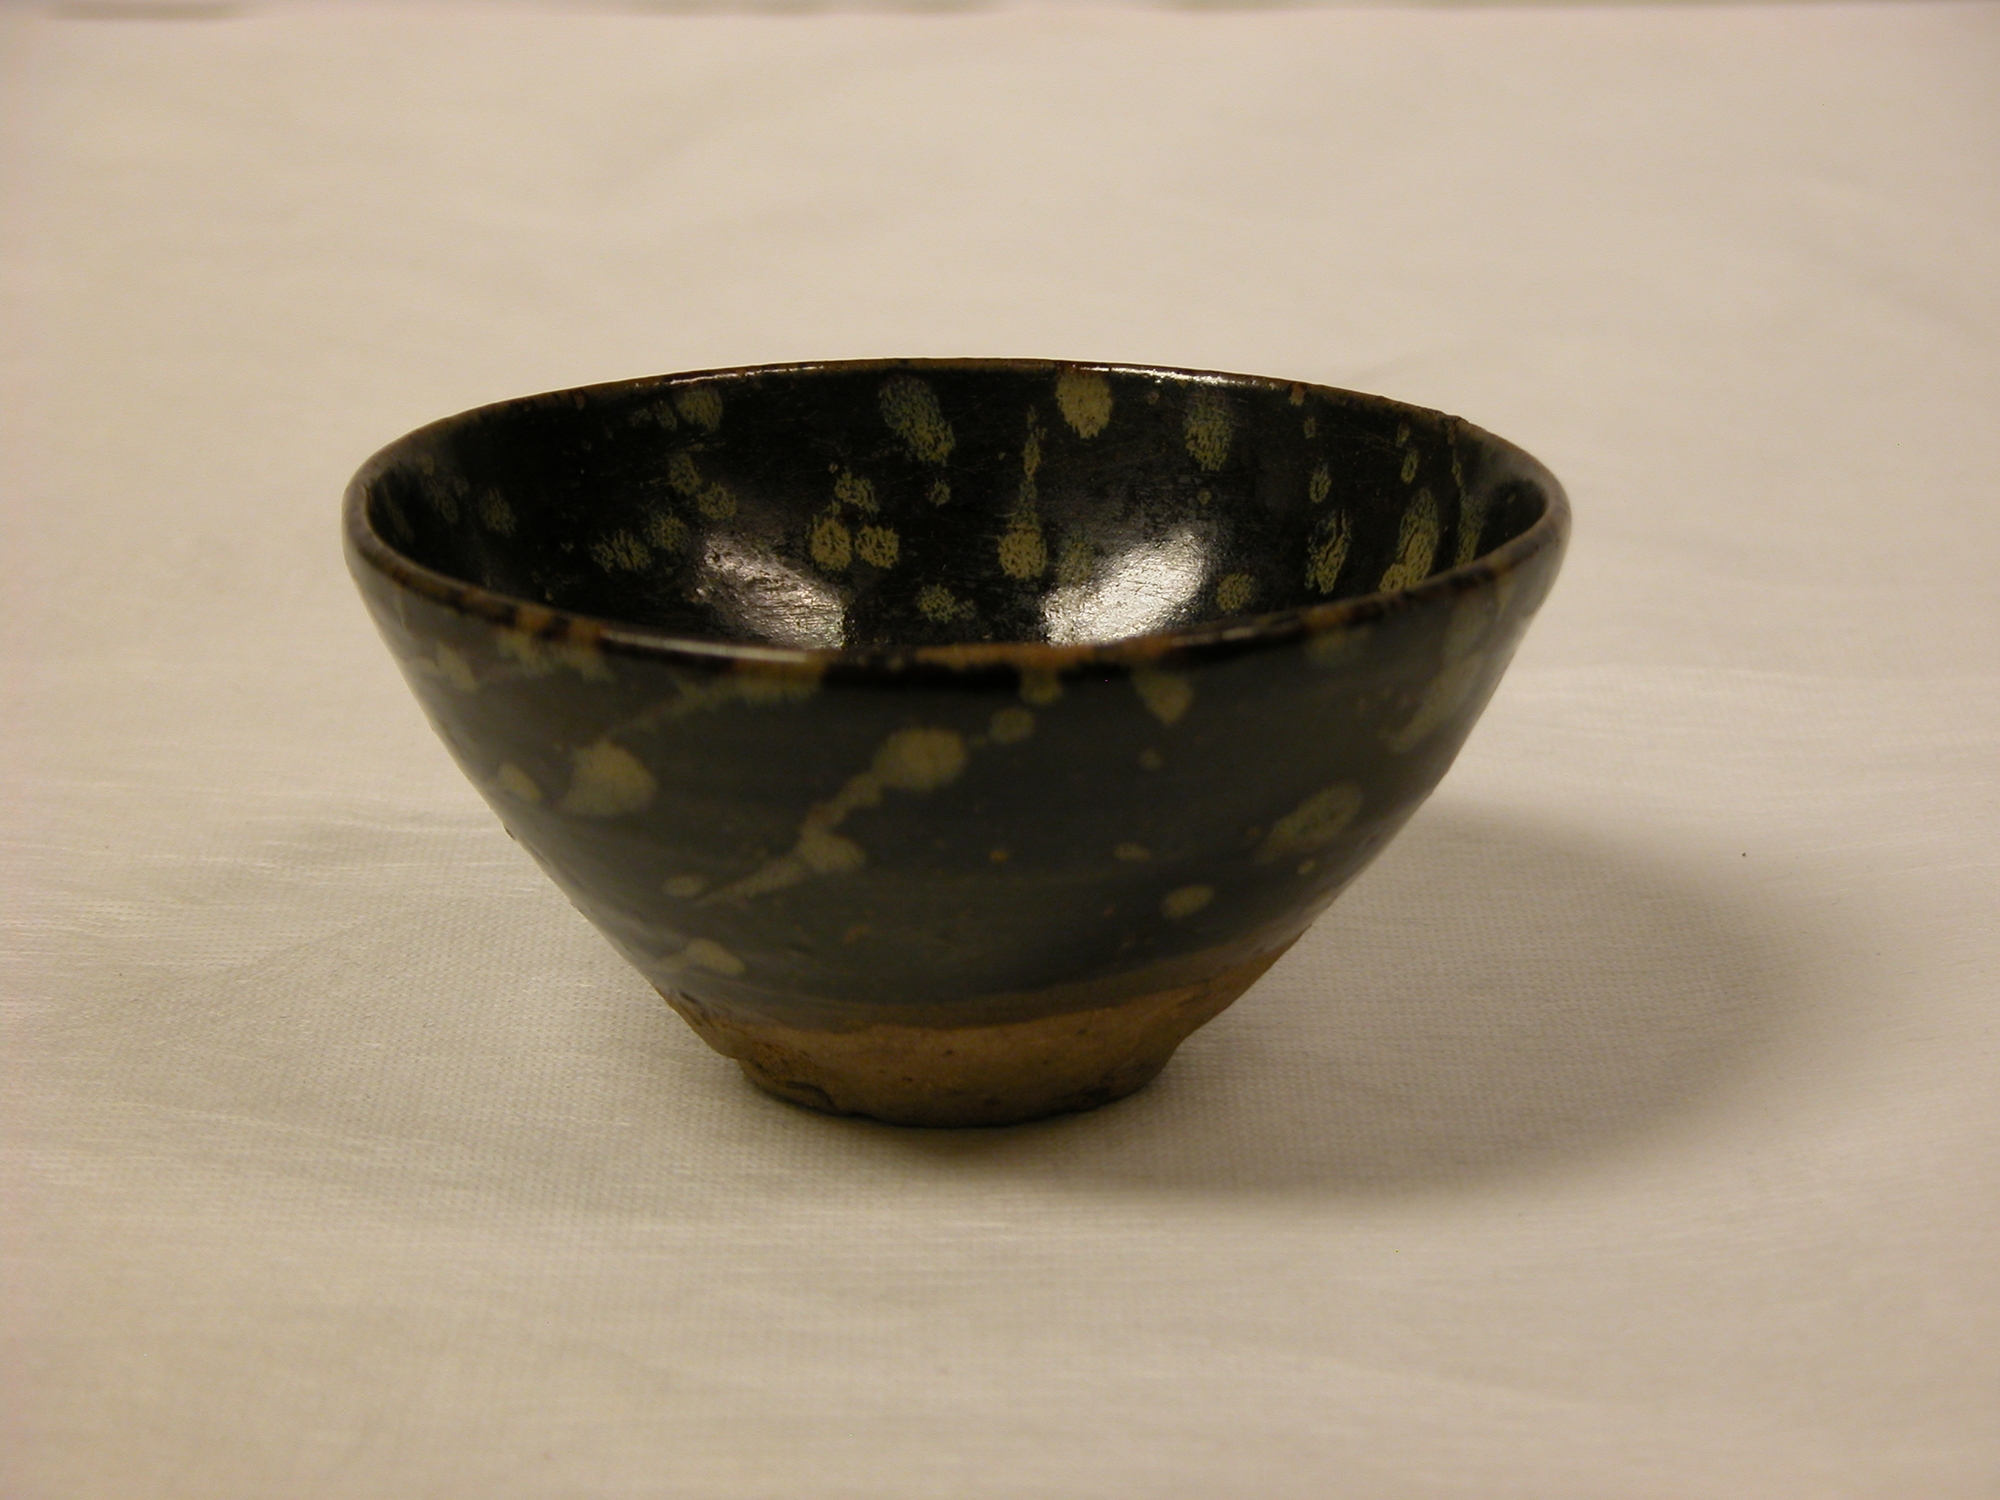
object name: bowl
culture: chinese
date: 1201-1400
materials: glaze, stoneware, shell